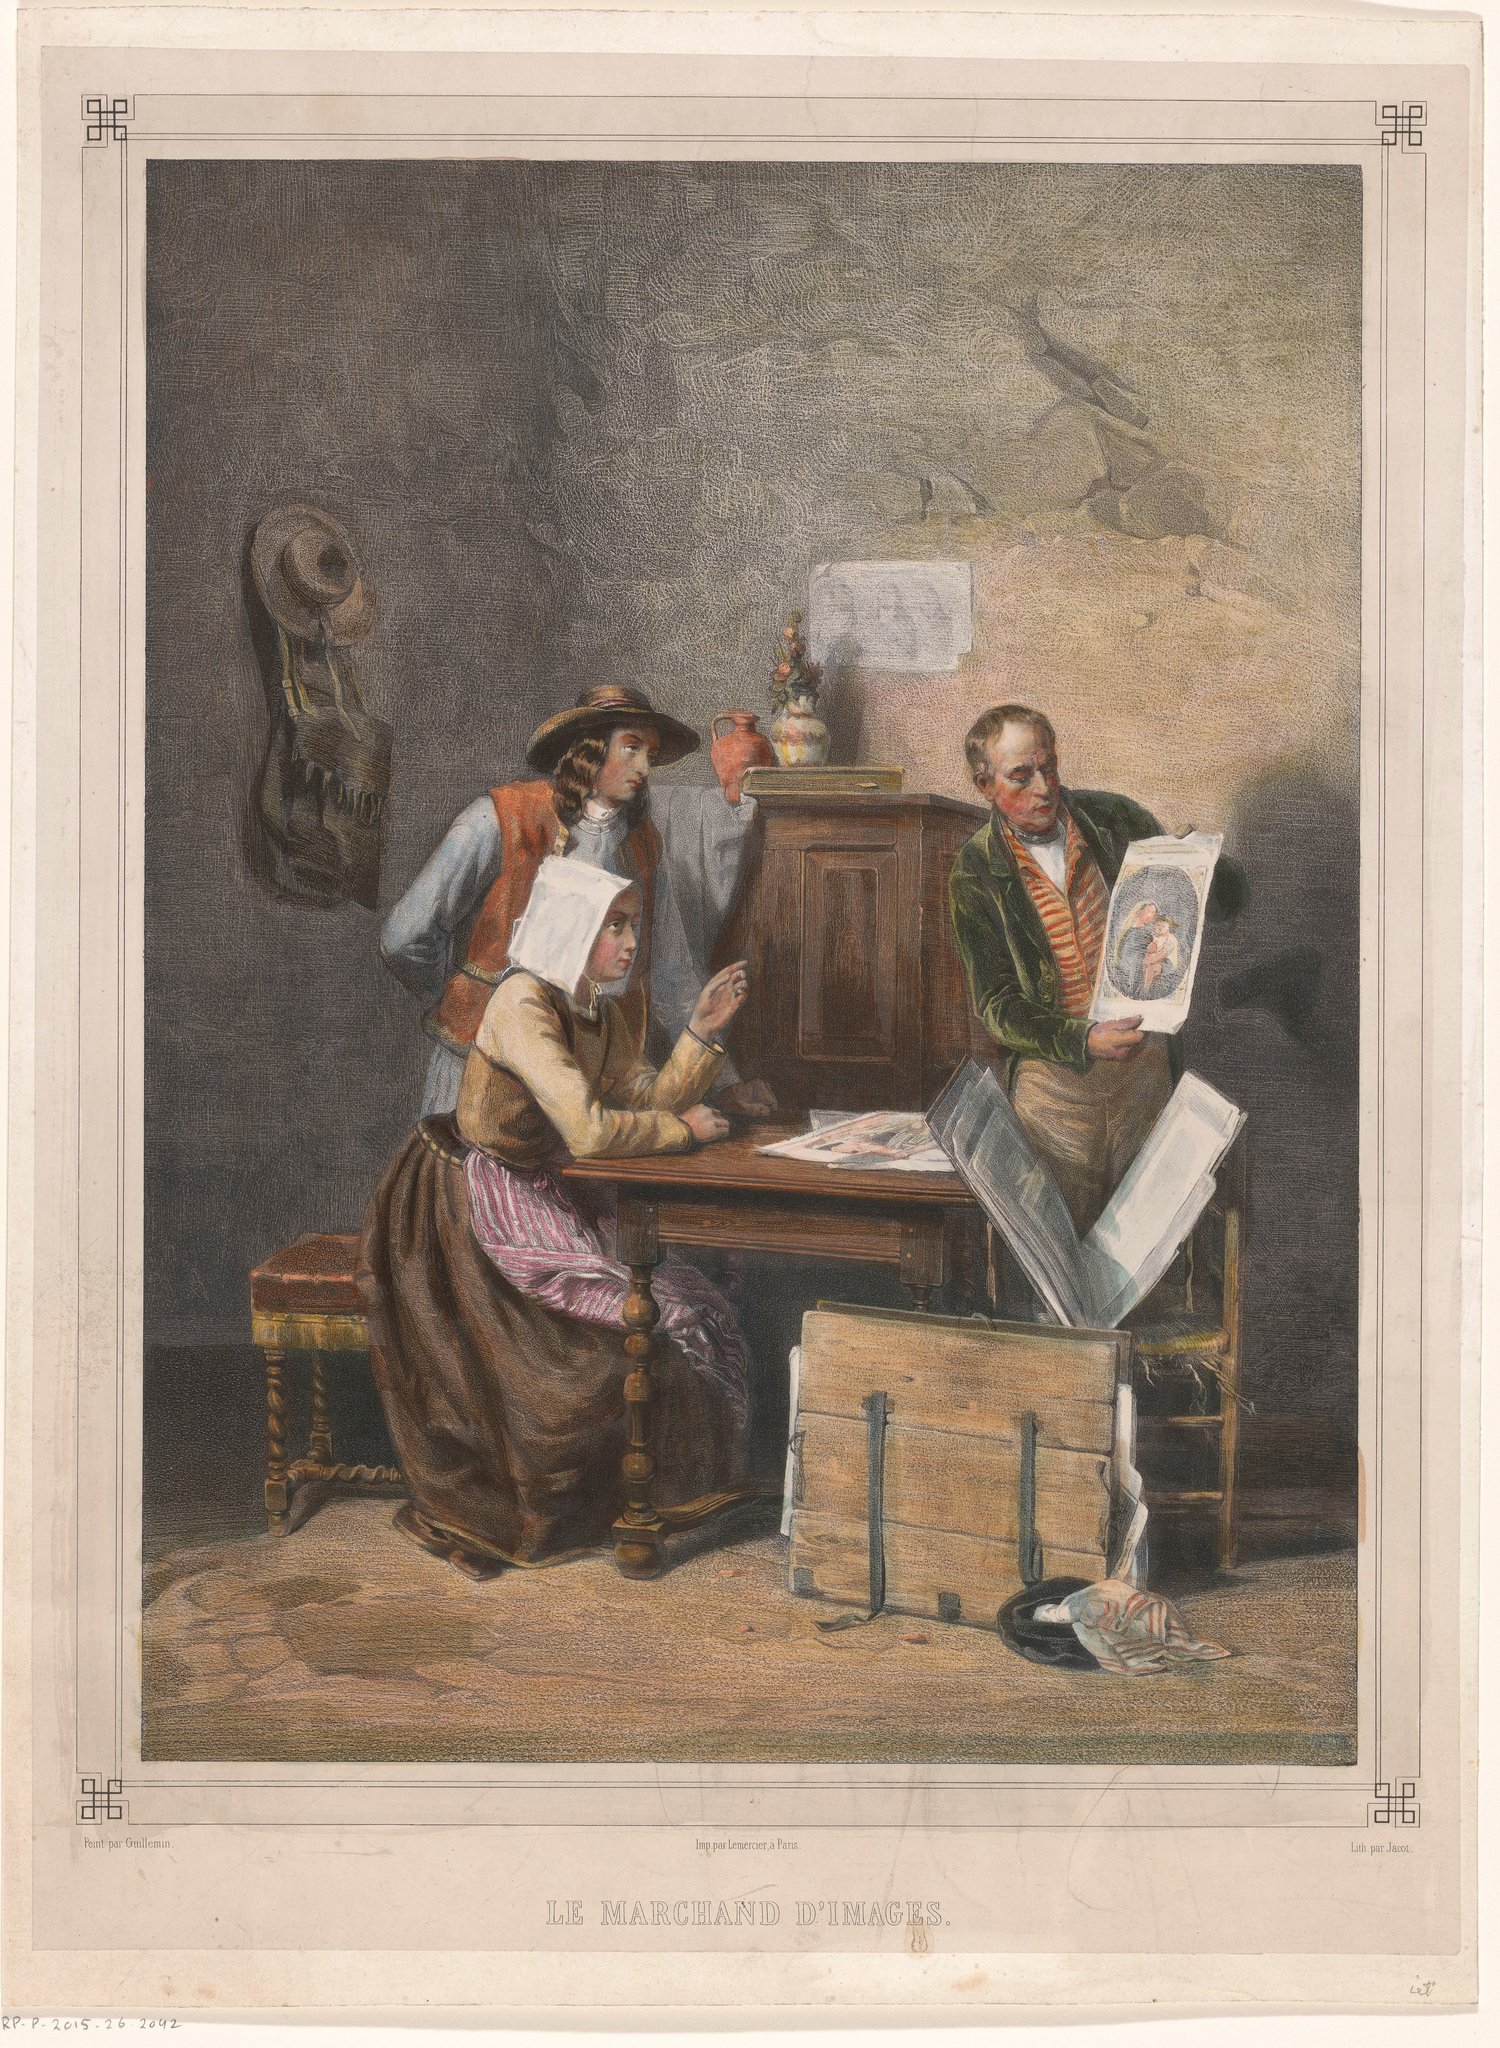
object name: print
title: Prenthandelaar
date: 1850-1900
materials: paper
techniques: hand coloring, lithograph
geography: paris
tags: print, e.g.: engraving, etching, lithograph, art dealer (+ graphic arts), book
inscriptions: collector's mark: Lugt 4779, collector's mark: Lugt 4780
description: Interieur met een rondreizende prenthandelaar die zijn voorraad toont aan een man en een vrouw in eenvoudige kleding. Op de stoel staat een opengeslagen map en tegen de tafelpoot leunt een houten kist om prenten in te vervoeren. In de achtergrond ligt een boek op de kast; aan de muur hangt een prent.